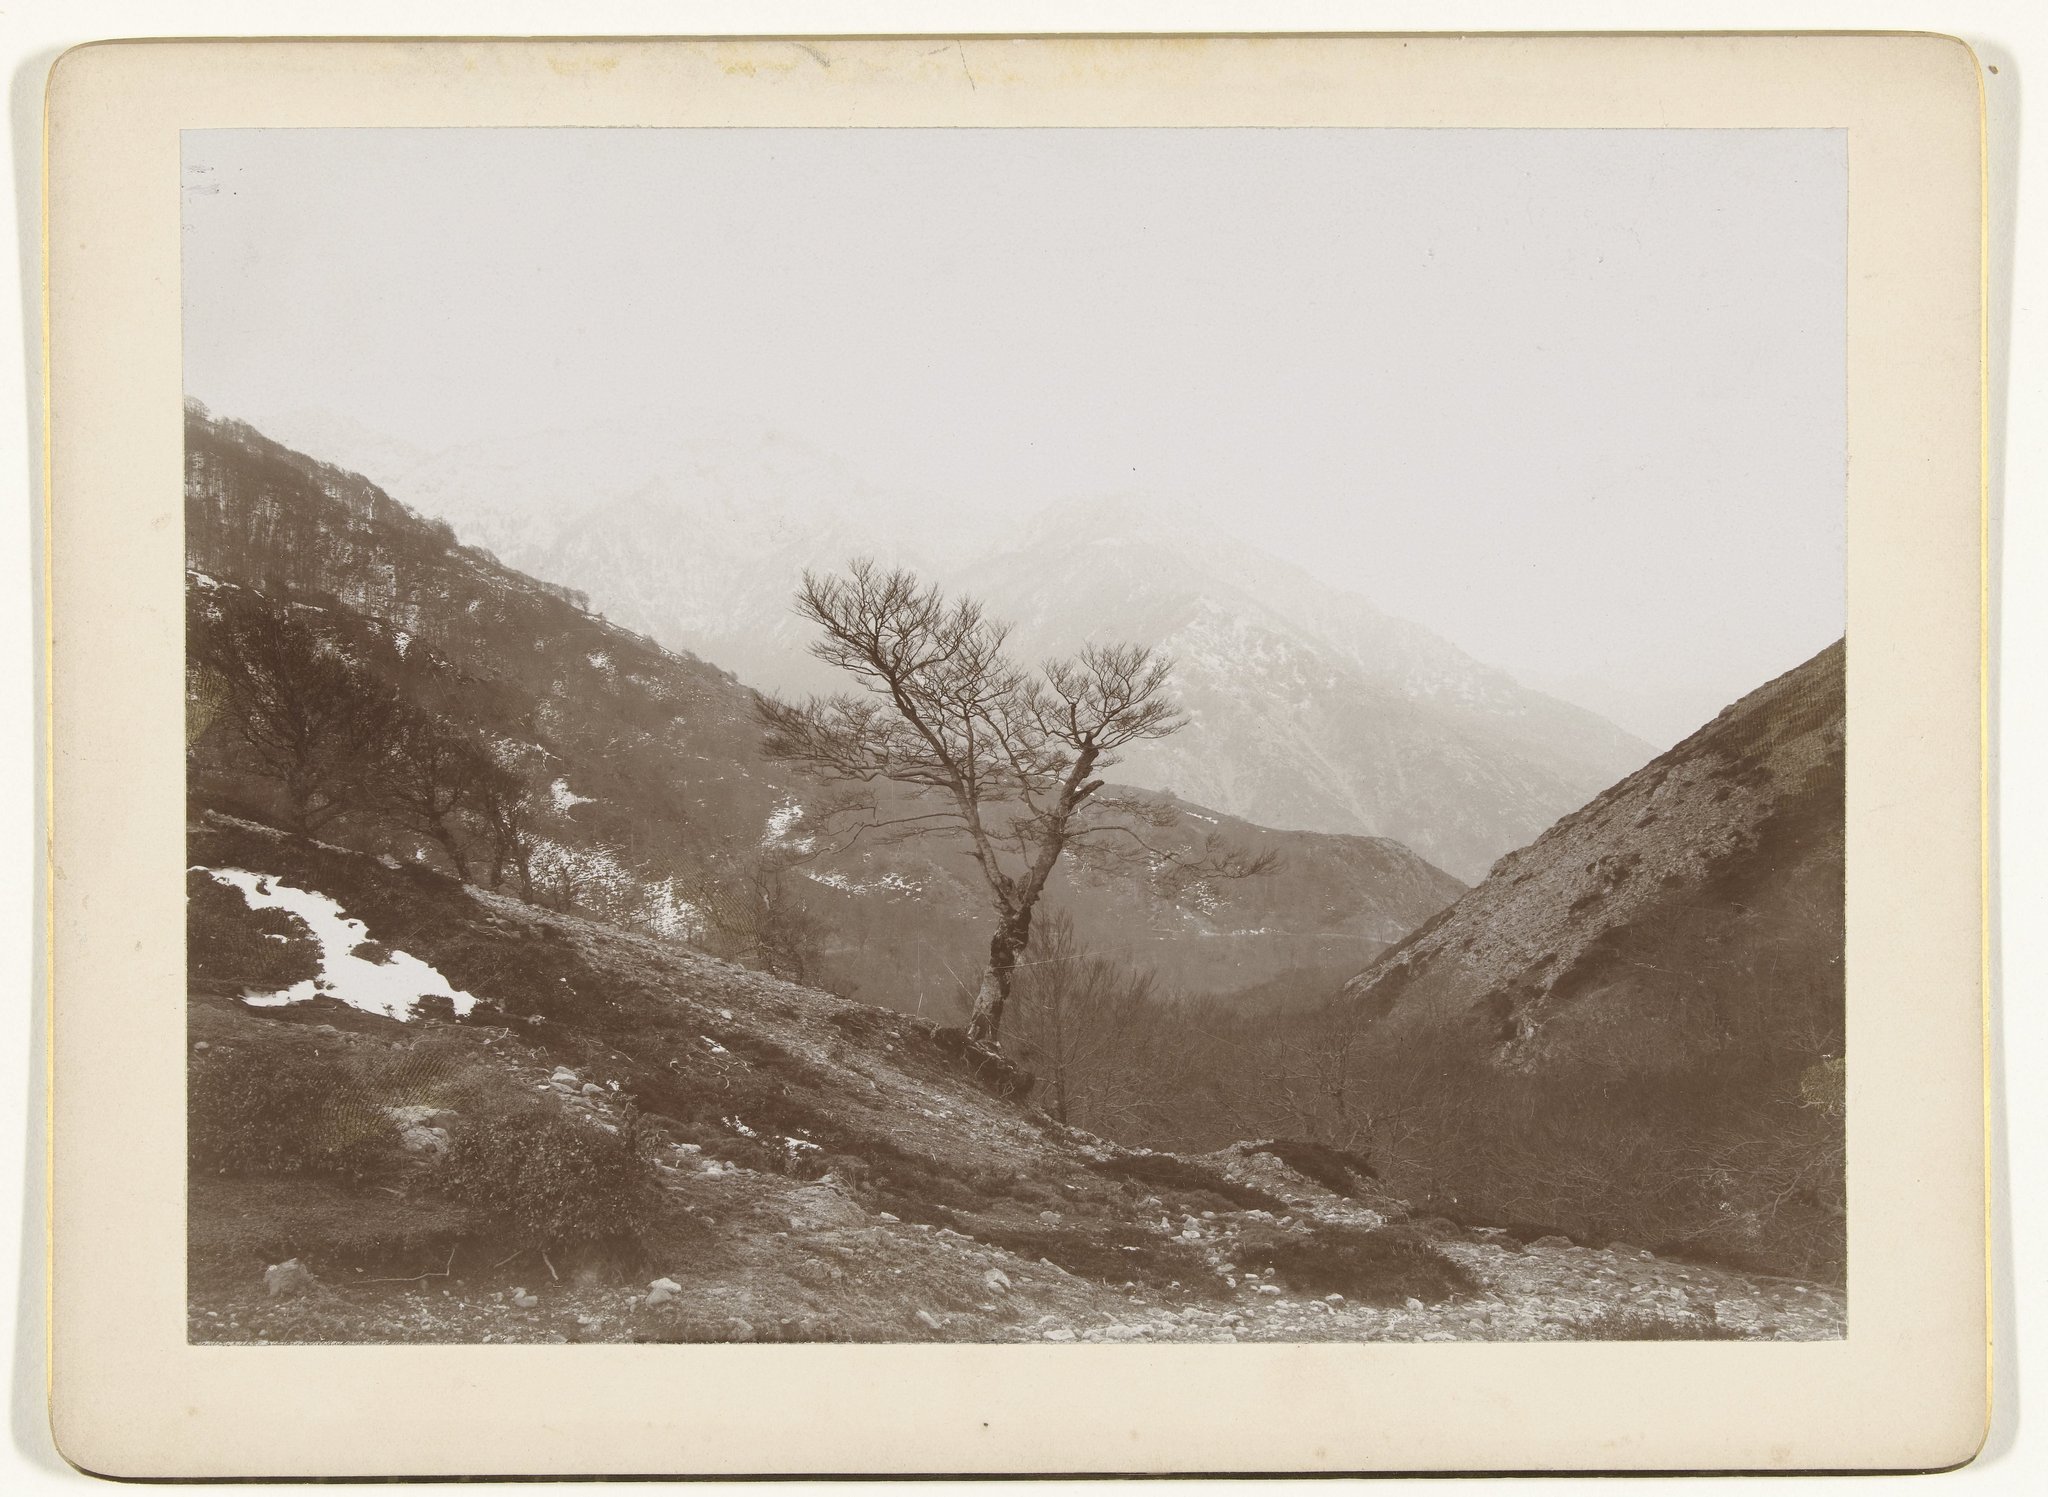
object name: photograph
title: Berglandschap met kale boom en enige sneeuw, Italië of Frankrijk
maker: henry pauw van wieldrecht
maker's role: fotograaf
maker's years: 1863-1912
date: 1896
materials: cardboard, photographic support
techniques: gelatin silver print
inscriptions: annotation: ‘No. 1182. 1896.’